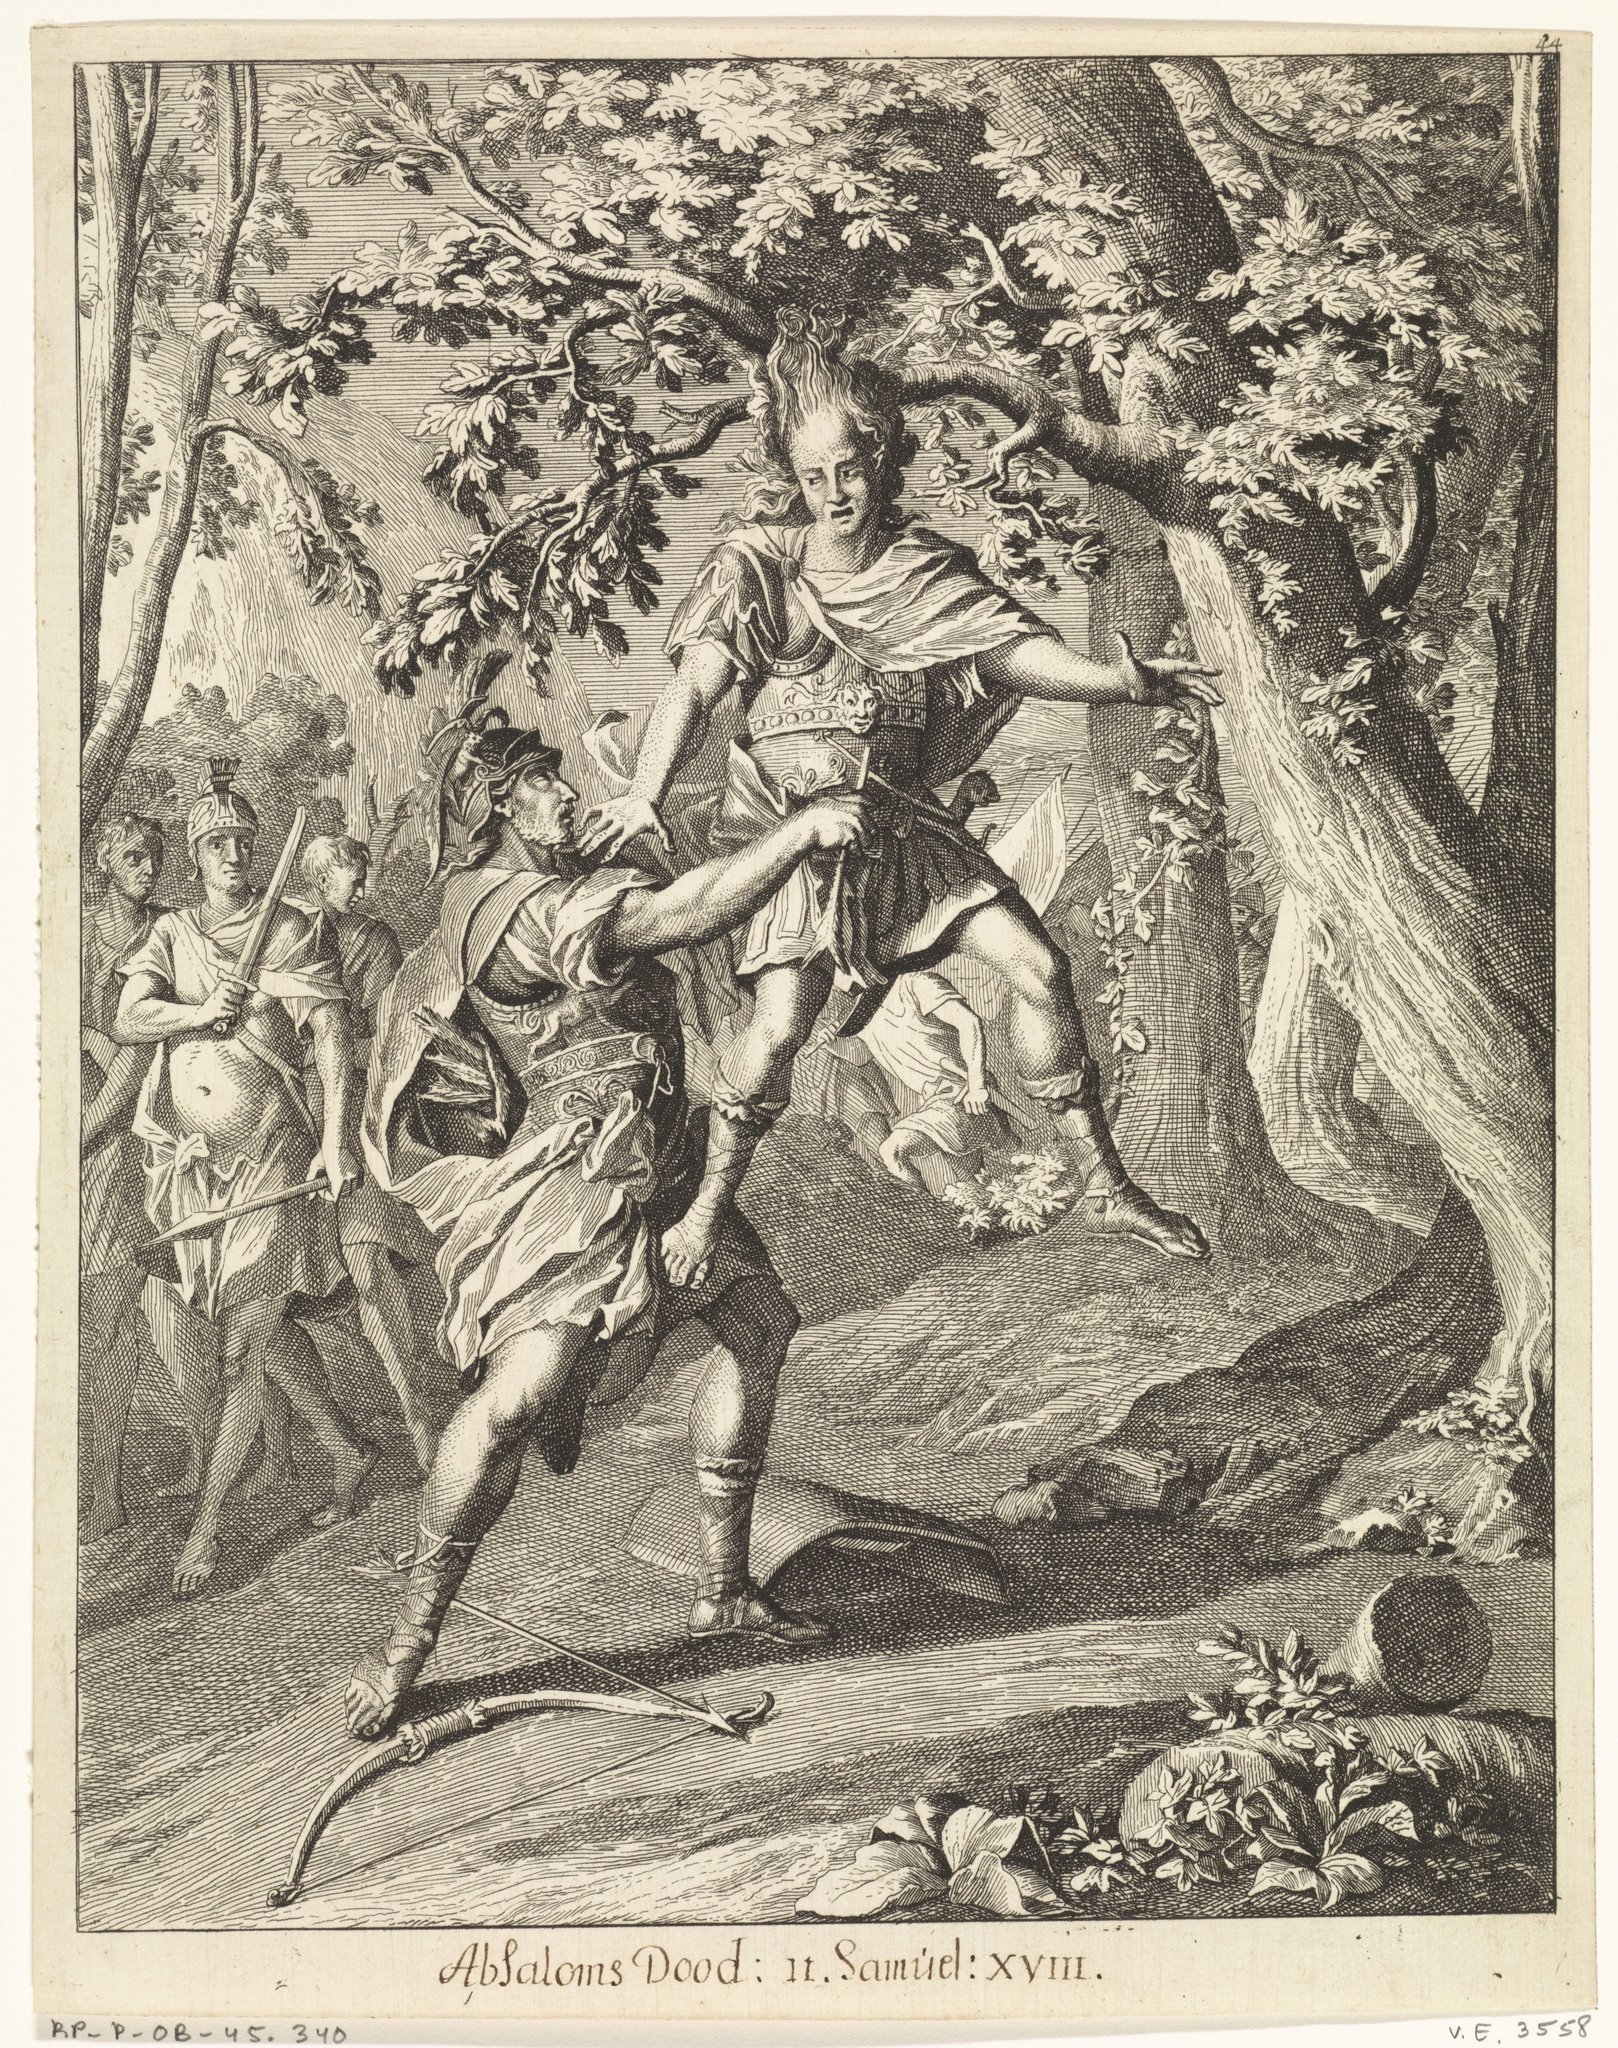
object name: print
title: Dood van Absalom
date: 1708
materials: paper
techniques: etching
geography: nuremberg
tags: joab stabs absalom with three spears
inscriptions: collector's mark: Lugt 2228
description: Proefdruk van een prent welke is opgenomen als illustratie in: Historiae Celebriores Veteris Testamenti. Christoph Weigel, 1708.